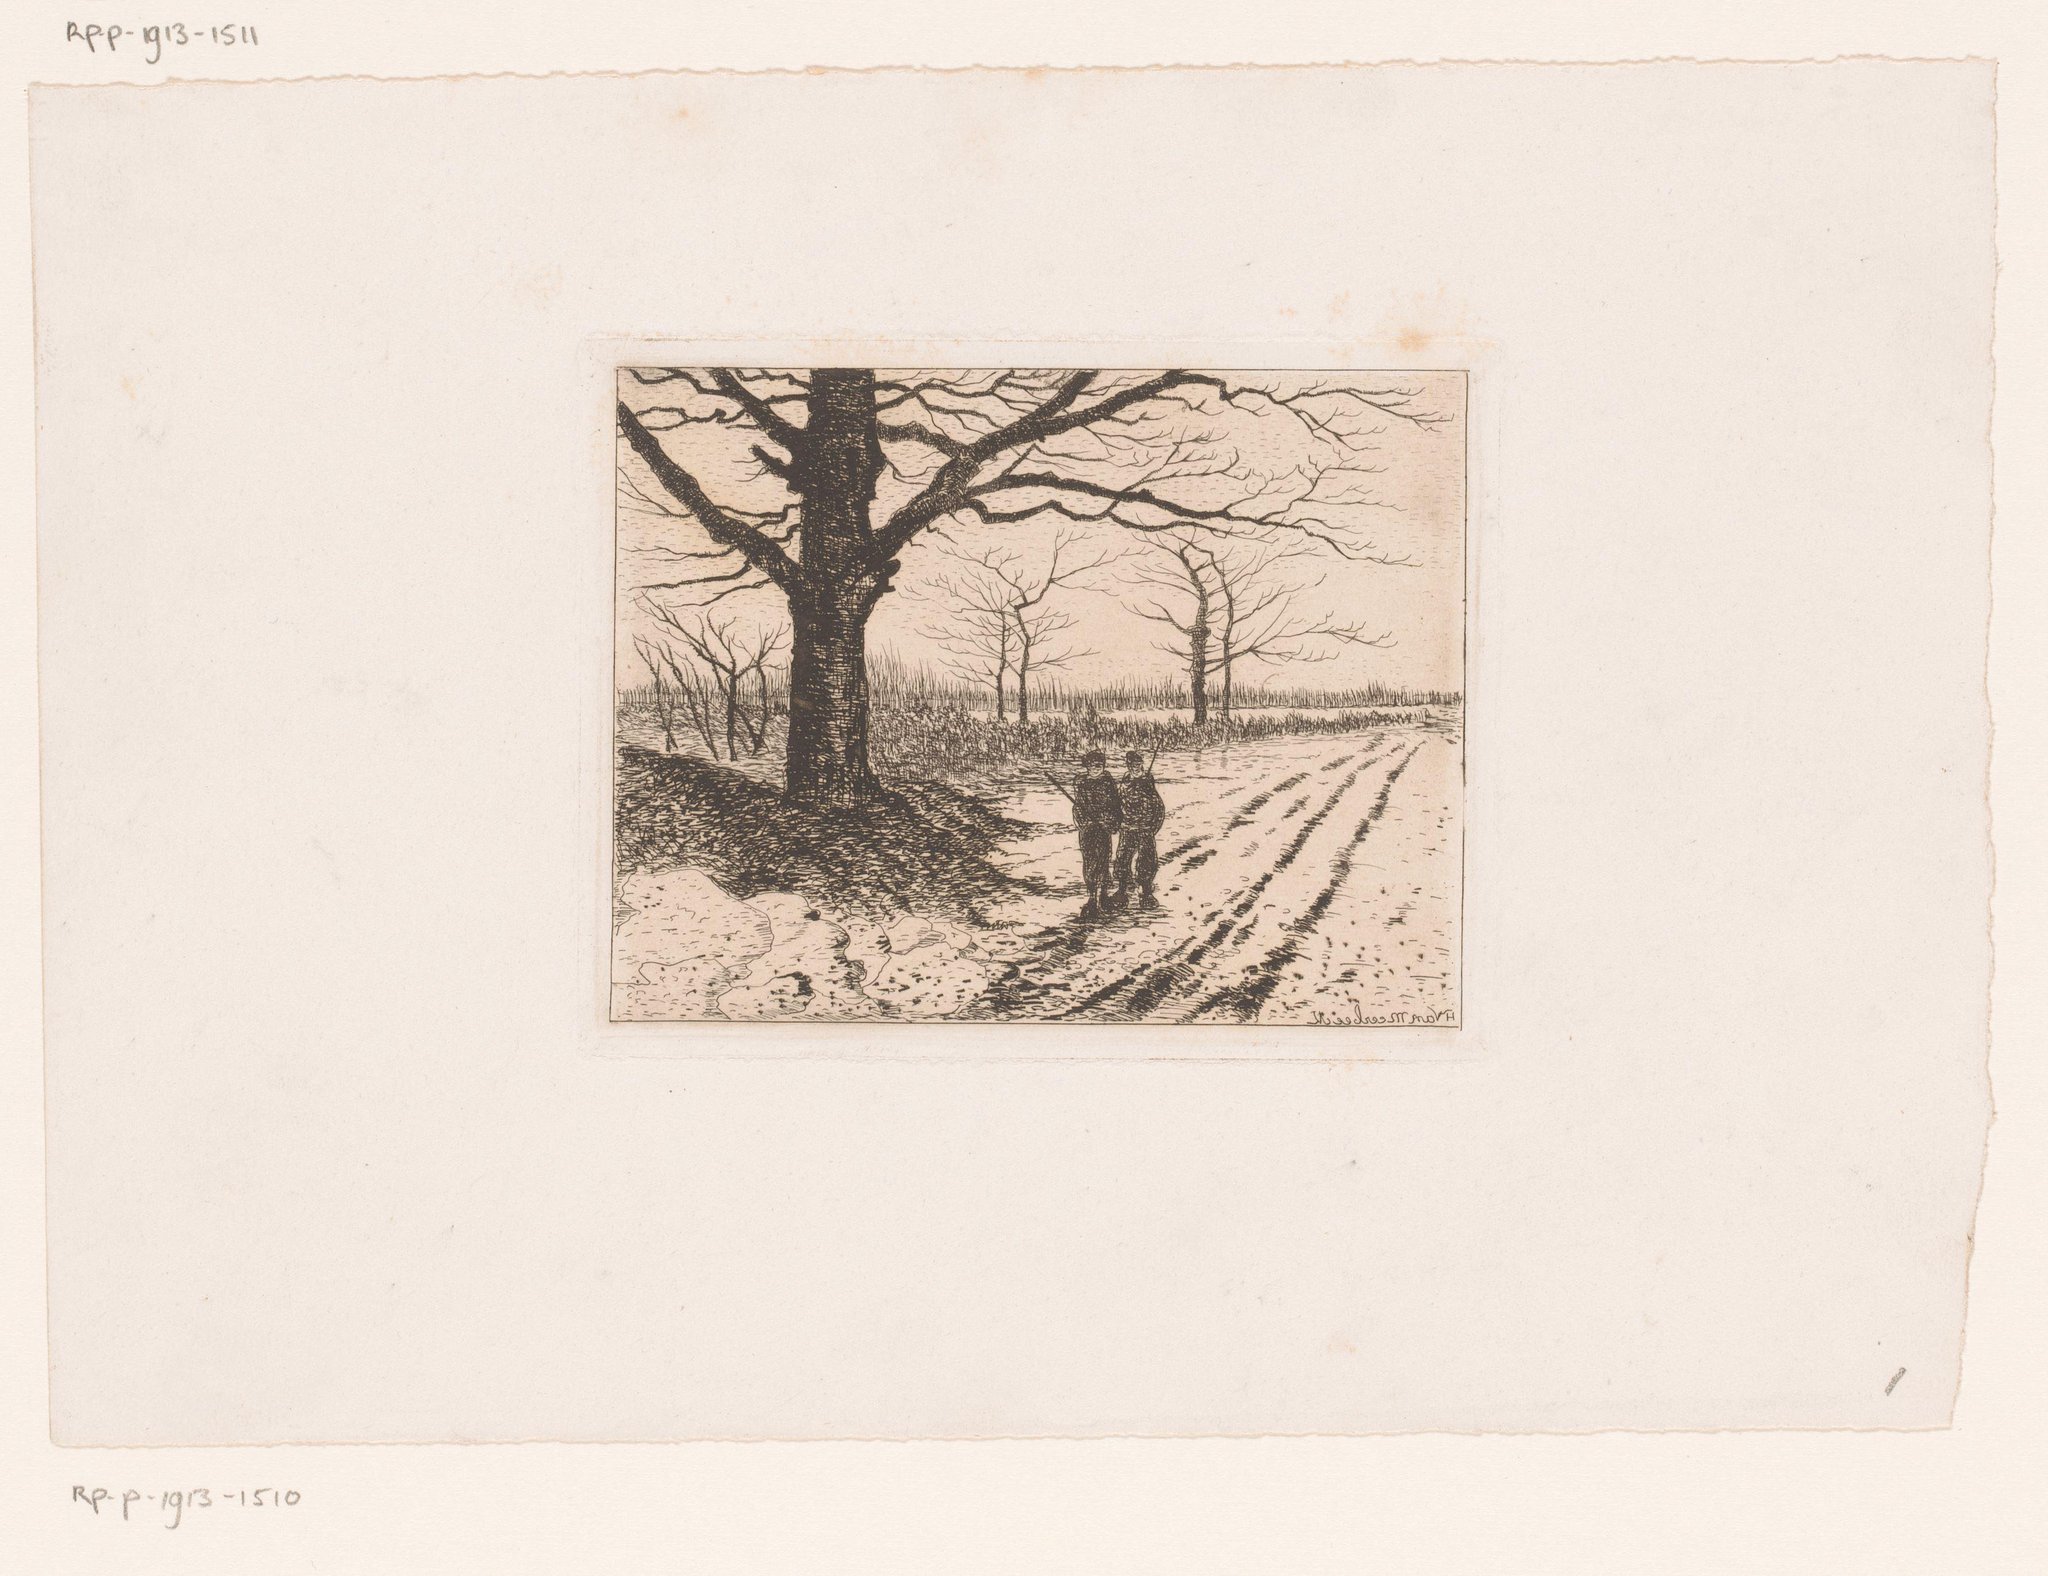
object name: print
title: Landschap met twee wandelaars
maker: h. van meerbeeck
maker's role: print maker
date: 1850-1913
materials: paper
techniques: etching, intaglio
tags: road, path, walking, landscapes (+ landscape with figures, staffage)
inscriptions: collector's mark: Lugt 2228